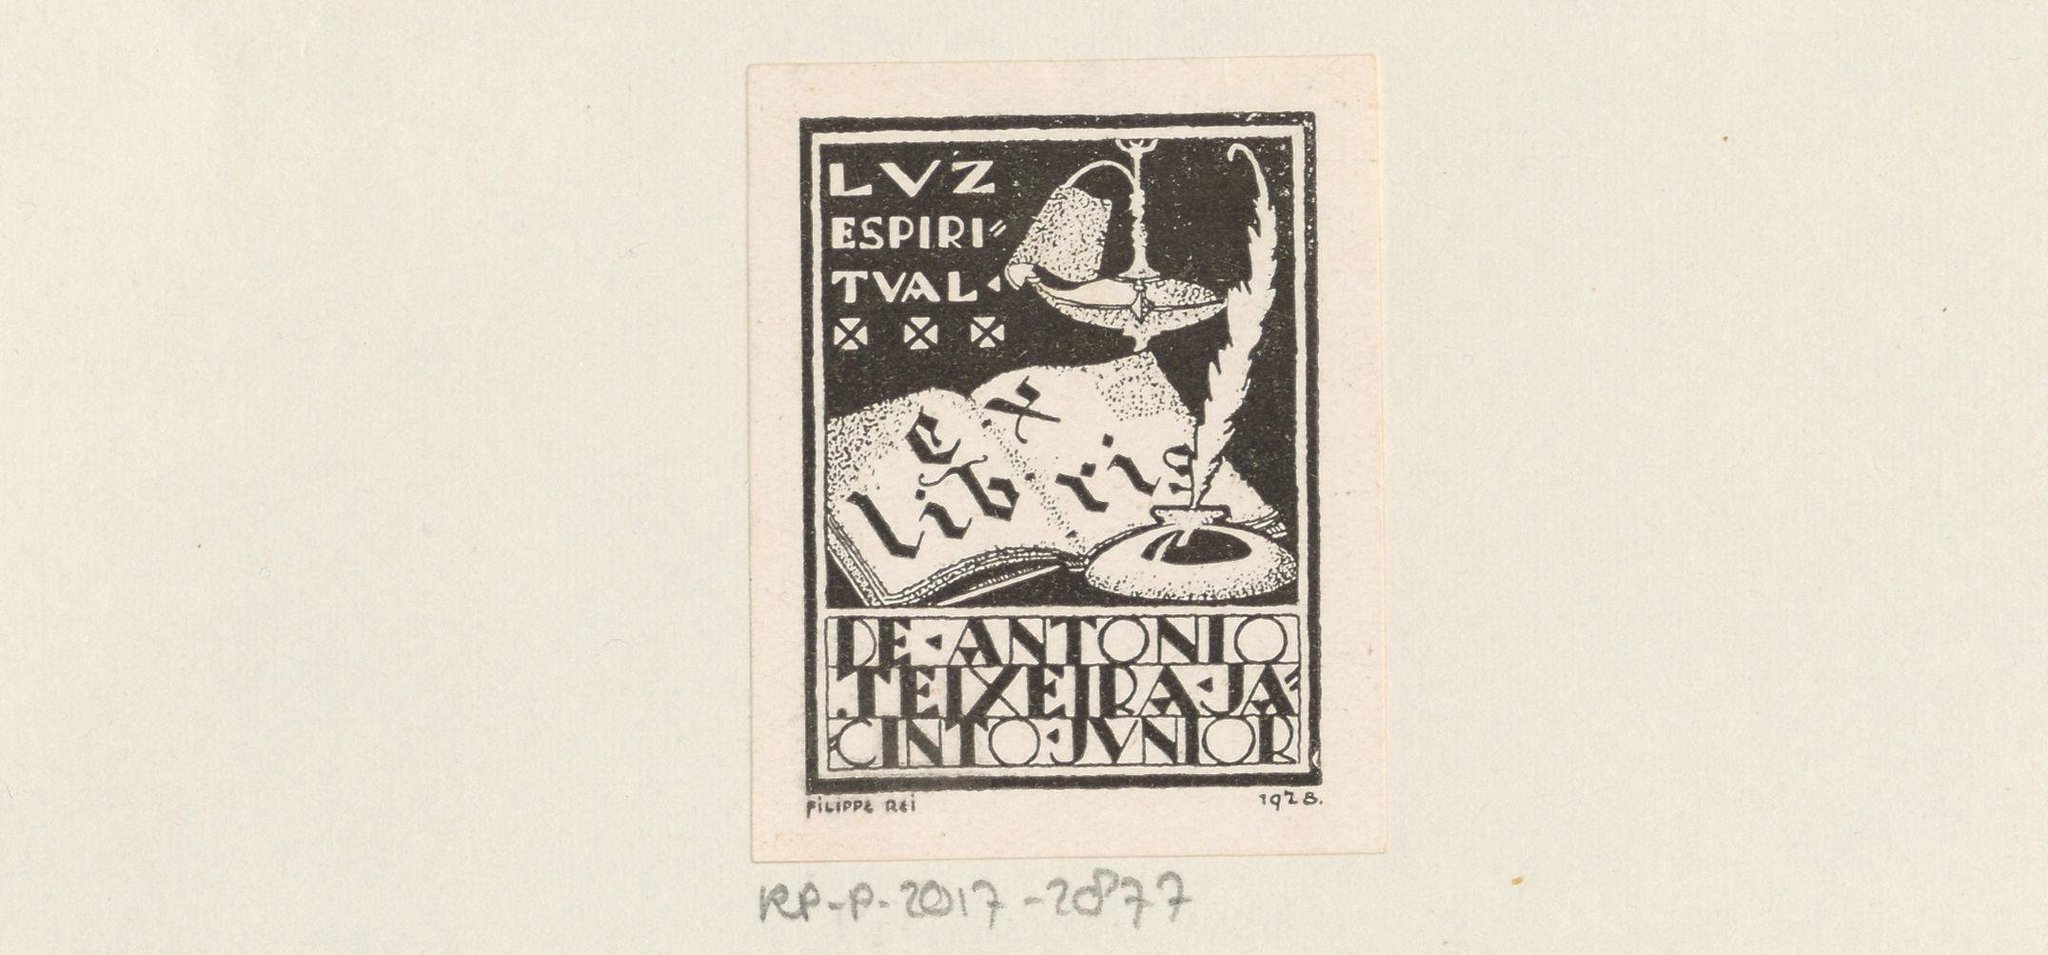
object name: bookplate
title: Ex libris van Antonio Teixeira Jacinto junior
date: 1928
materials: paper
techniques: printing block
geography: portugal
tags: quill, book, oil-lamp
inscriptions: date